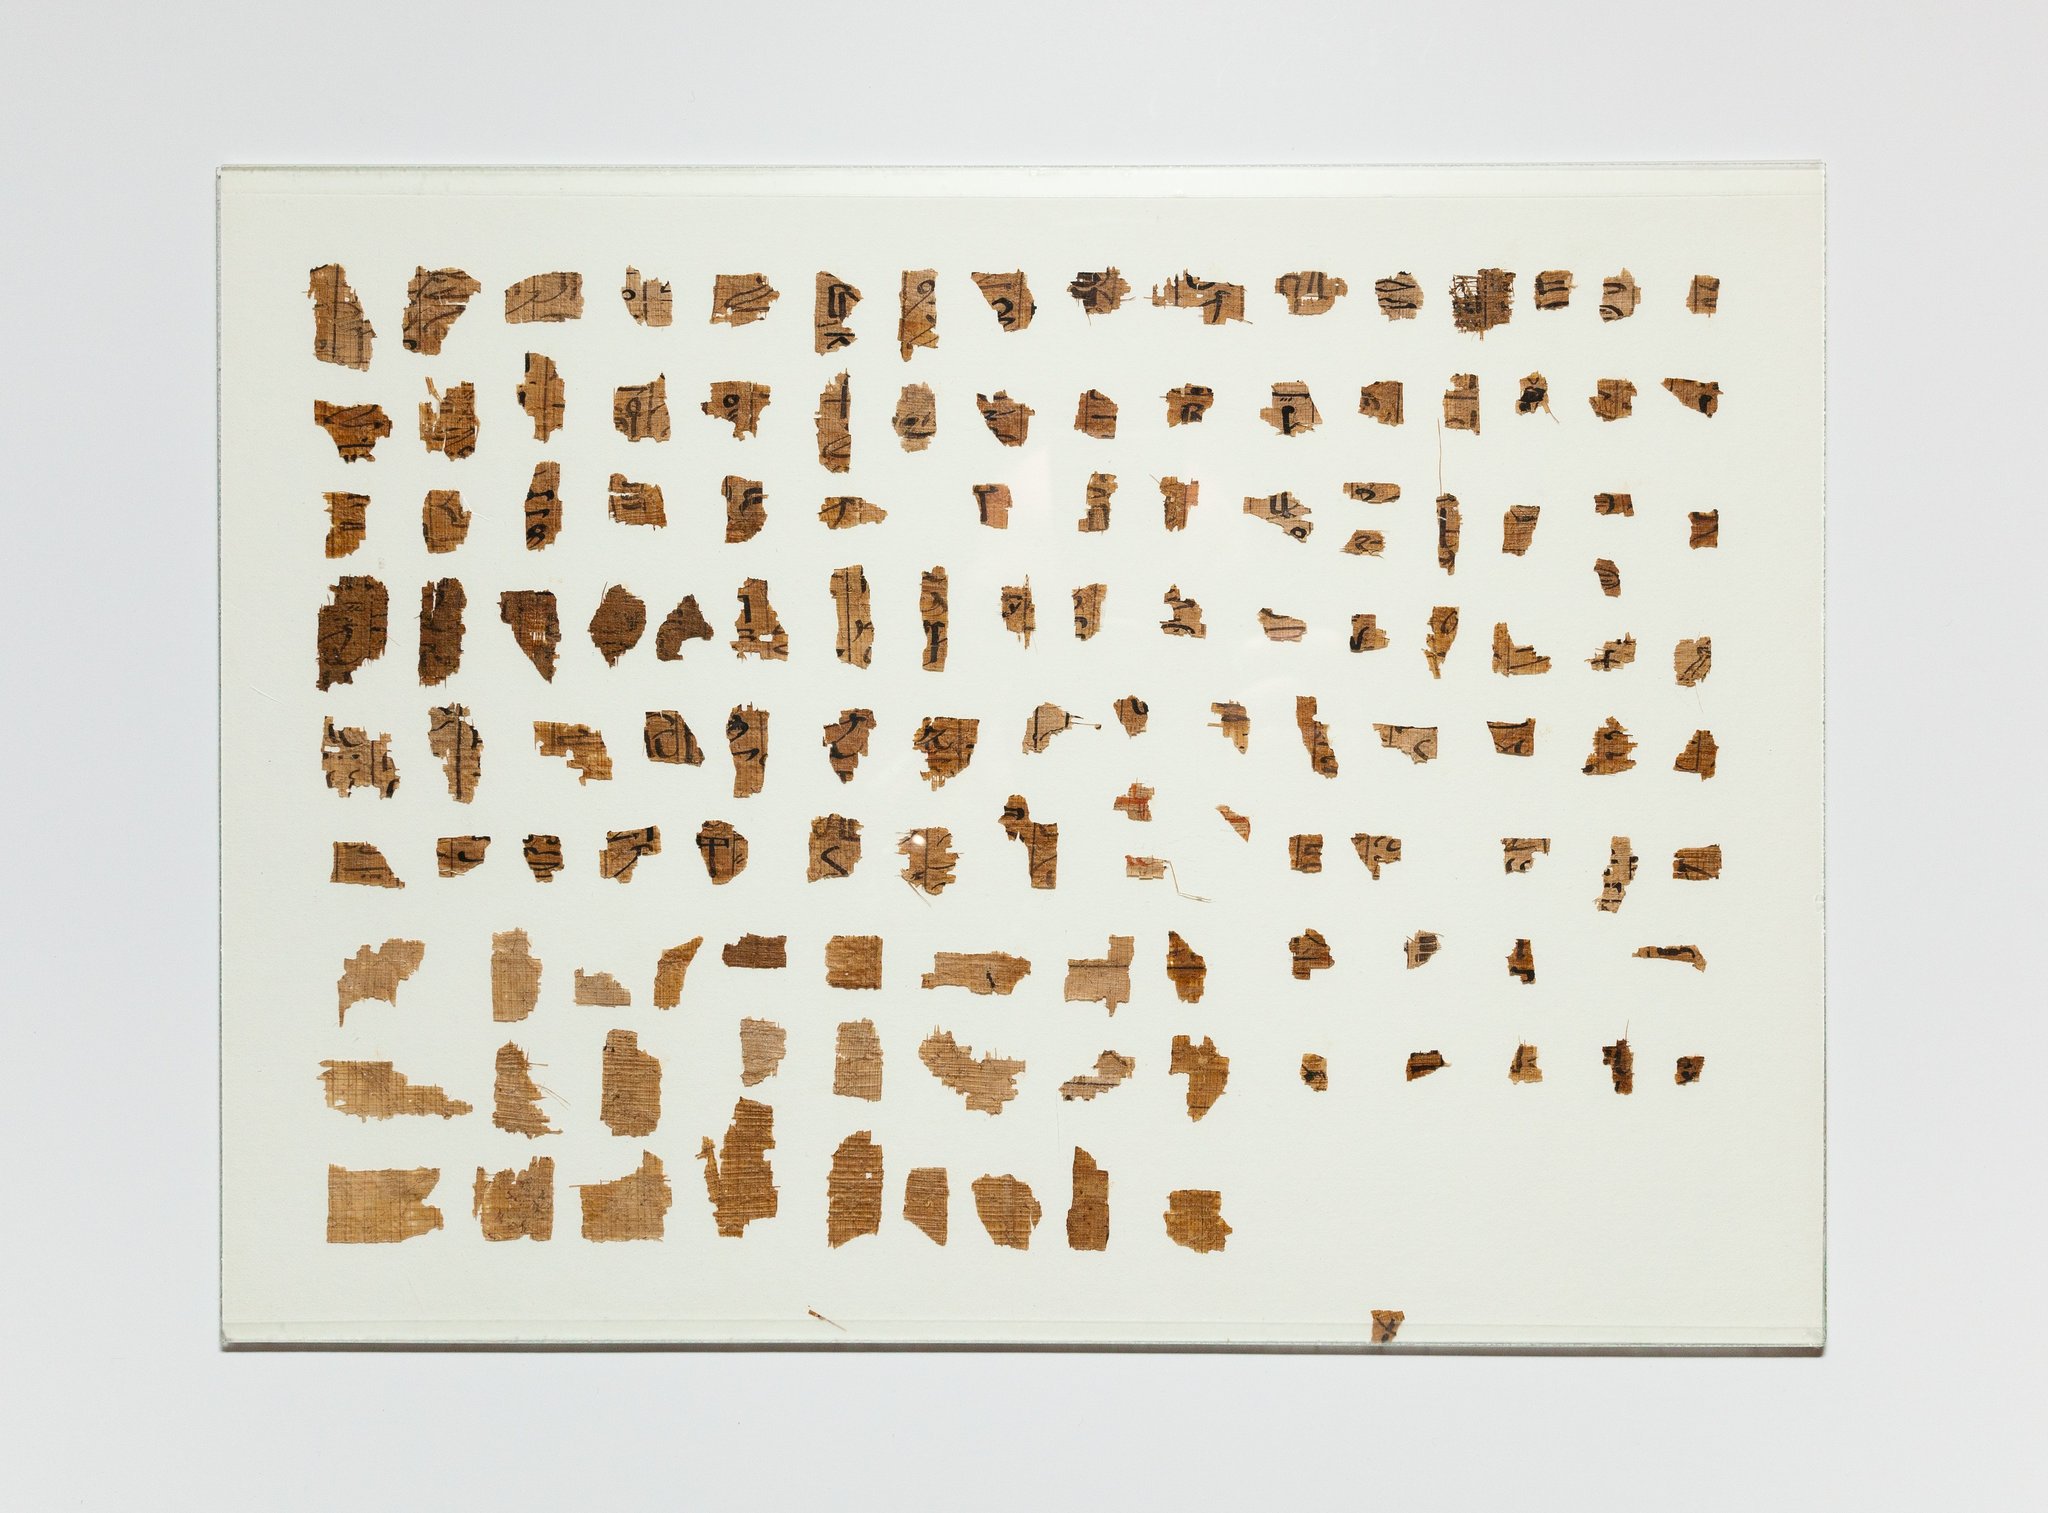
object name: papyrus, funerary, book of the dead, scribe roy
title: Papyrus fragments from the Book of the Dead of the Scribe Roy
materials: ink, papyrus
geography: egypt